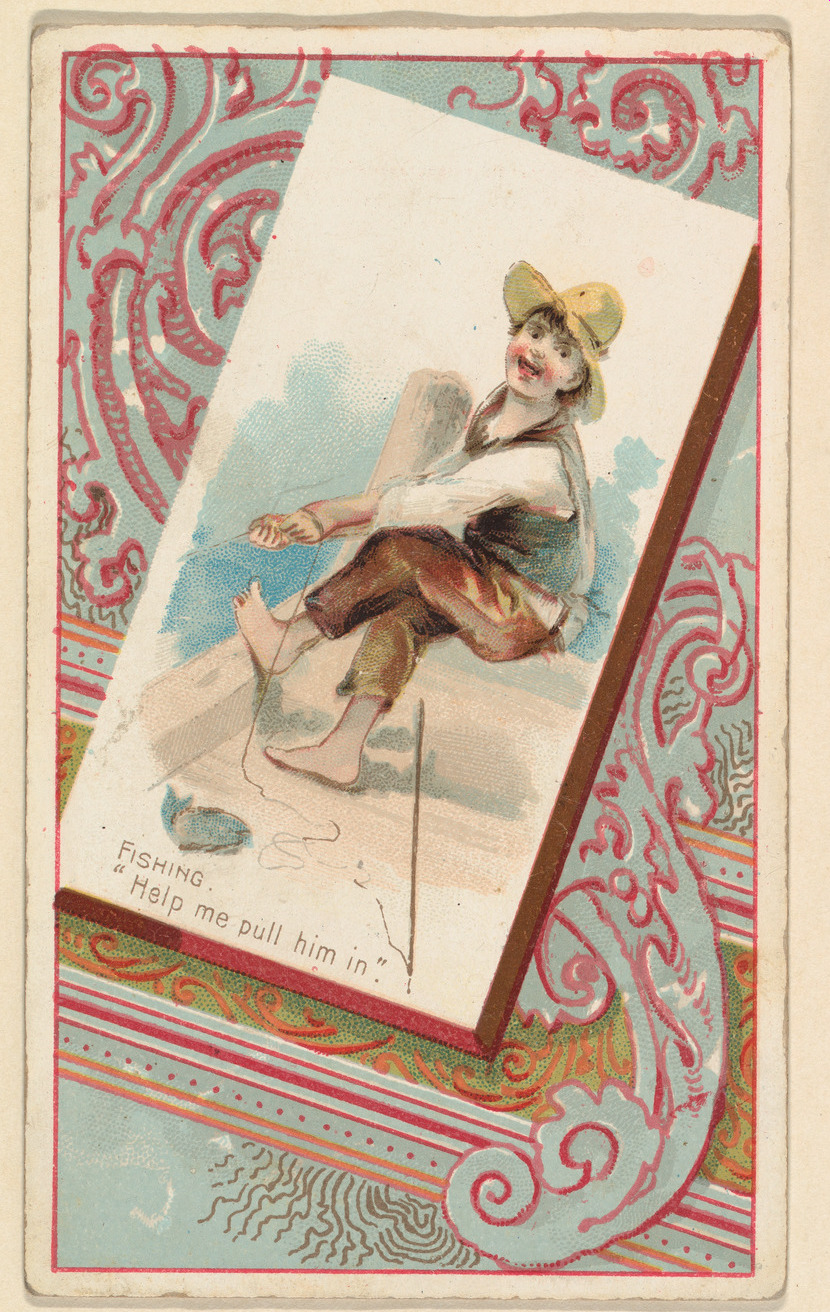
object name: print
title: Fishing, "Help me pull him in," from the Terrors of America set (N136) issued by Duke Sons & Co. to promote Honest Long Cut Tobacco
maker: w. duke, sons & co.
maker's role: publisher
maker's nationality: american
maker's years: 1870-1920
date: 1888-1889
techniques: color lithograph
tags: boys,fishing